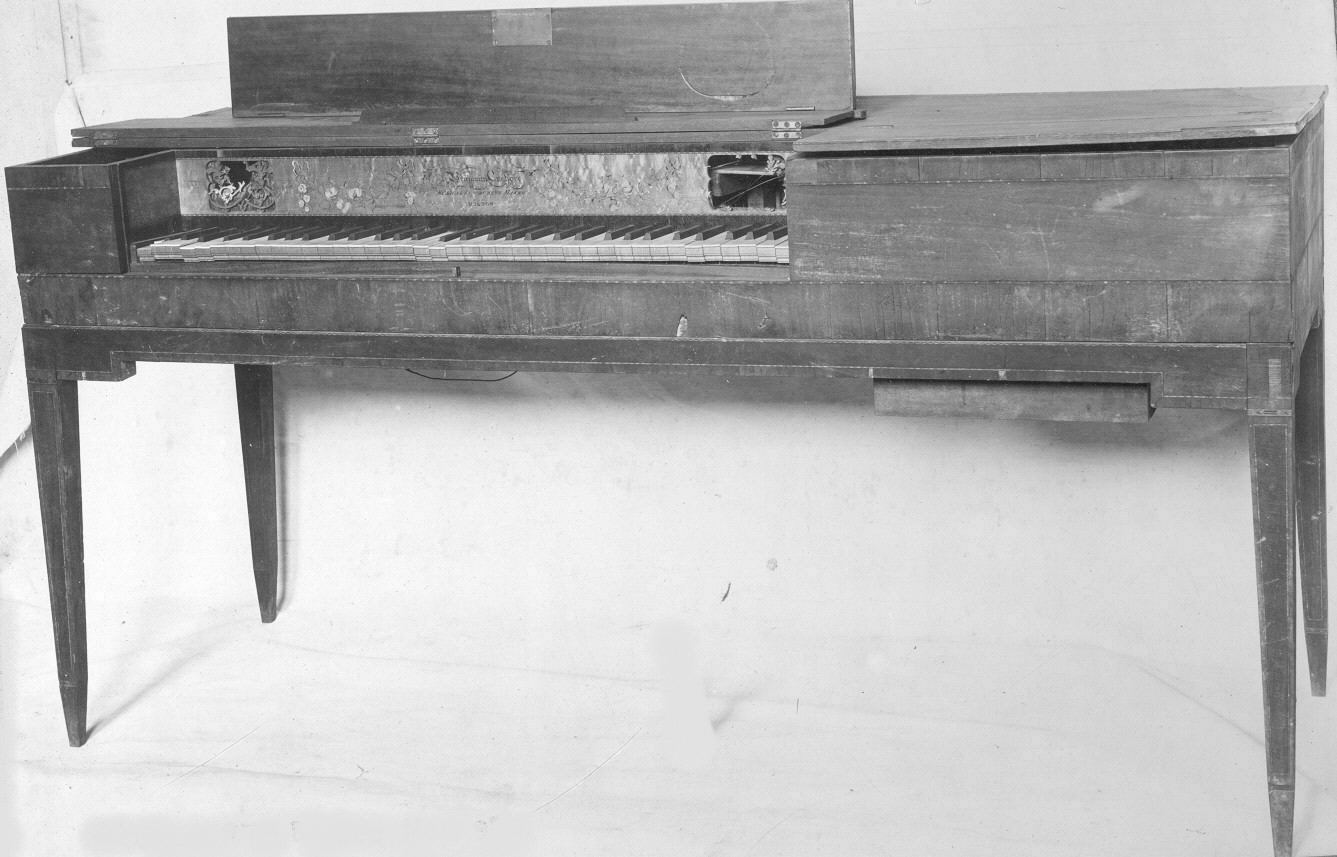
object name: square piano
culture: north american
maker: benjamin crehore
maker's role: maker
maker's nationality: american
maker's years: 1765-1831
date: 1800-1810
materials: brass, wood, iron, ivory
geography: united states